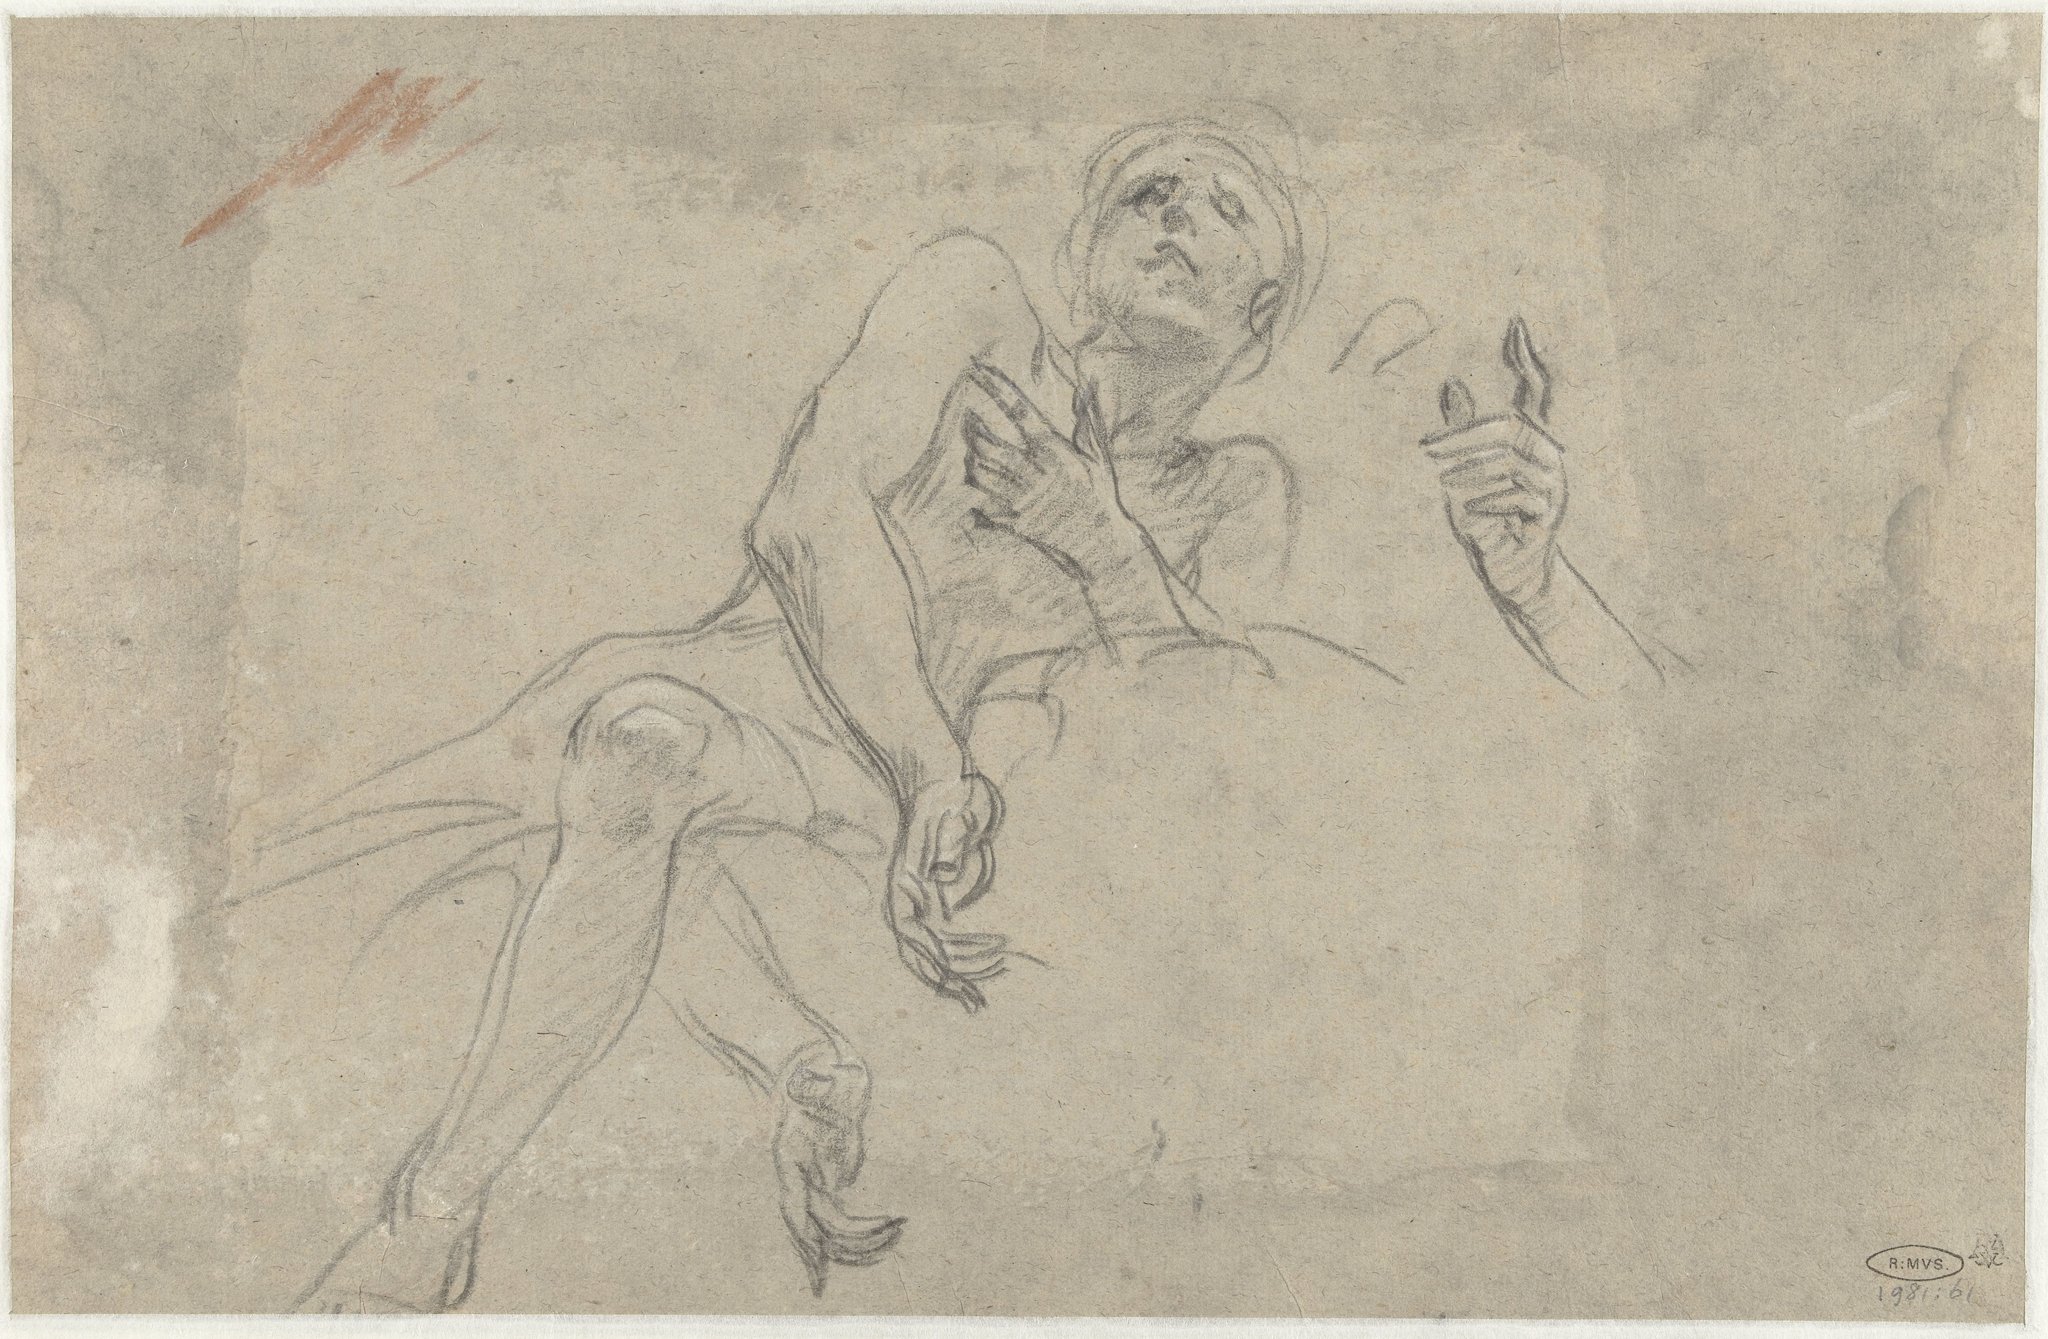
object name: drawing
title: Studie voor plafondschildering met een achterovergeleunde jongen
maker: baldassare franceschini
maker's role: draughtsman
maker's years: 1611-1689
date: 1621-1698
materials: chalk, paper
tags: boy (child between toddler and youth)